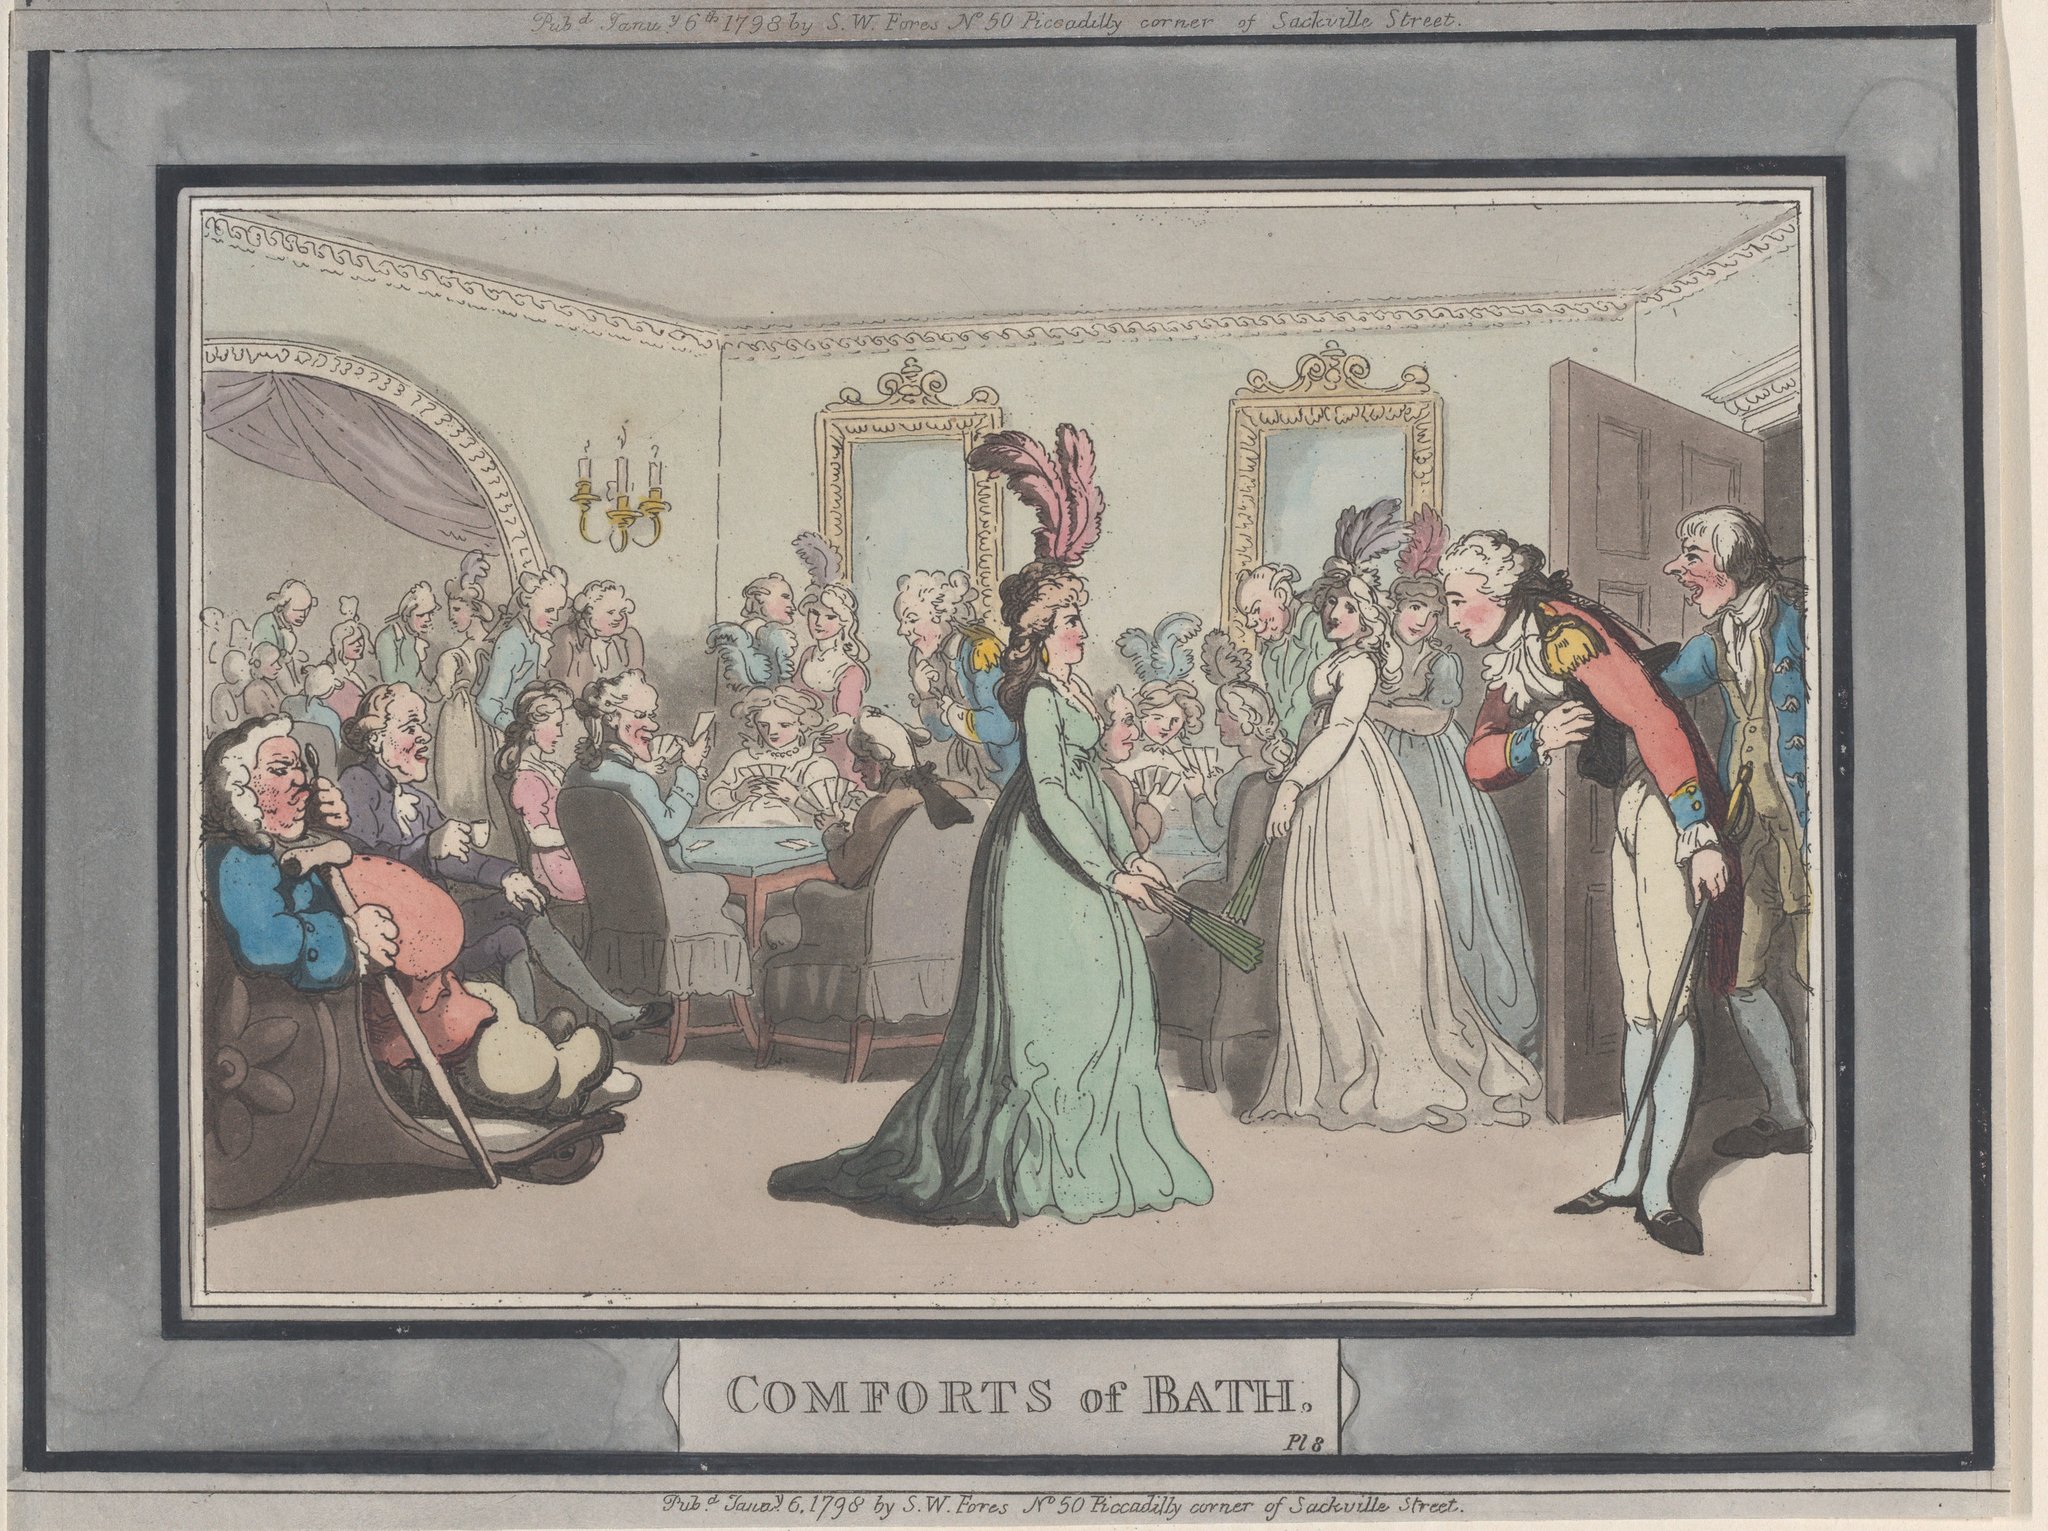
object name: print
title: Comforts of Bath, Plate 8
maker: thomas rowlandson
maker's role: artist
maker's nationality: british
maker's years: 1757-1827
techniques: aquatint, etching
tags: satire,men,women,playing cards